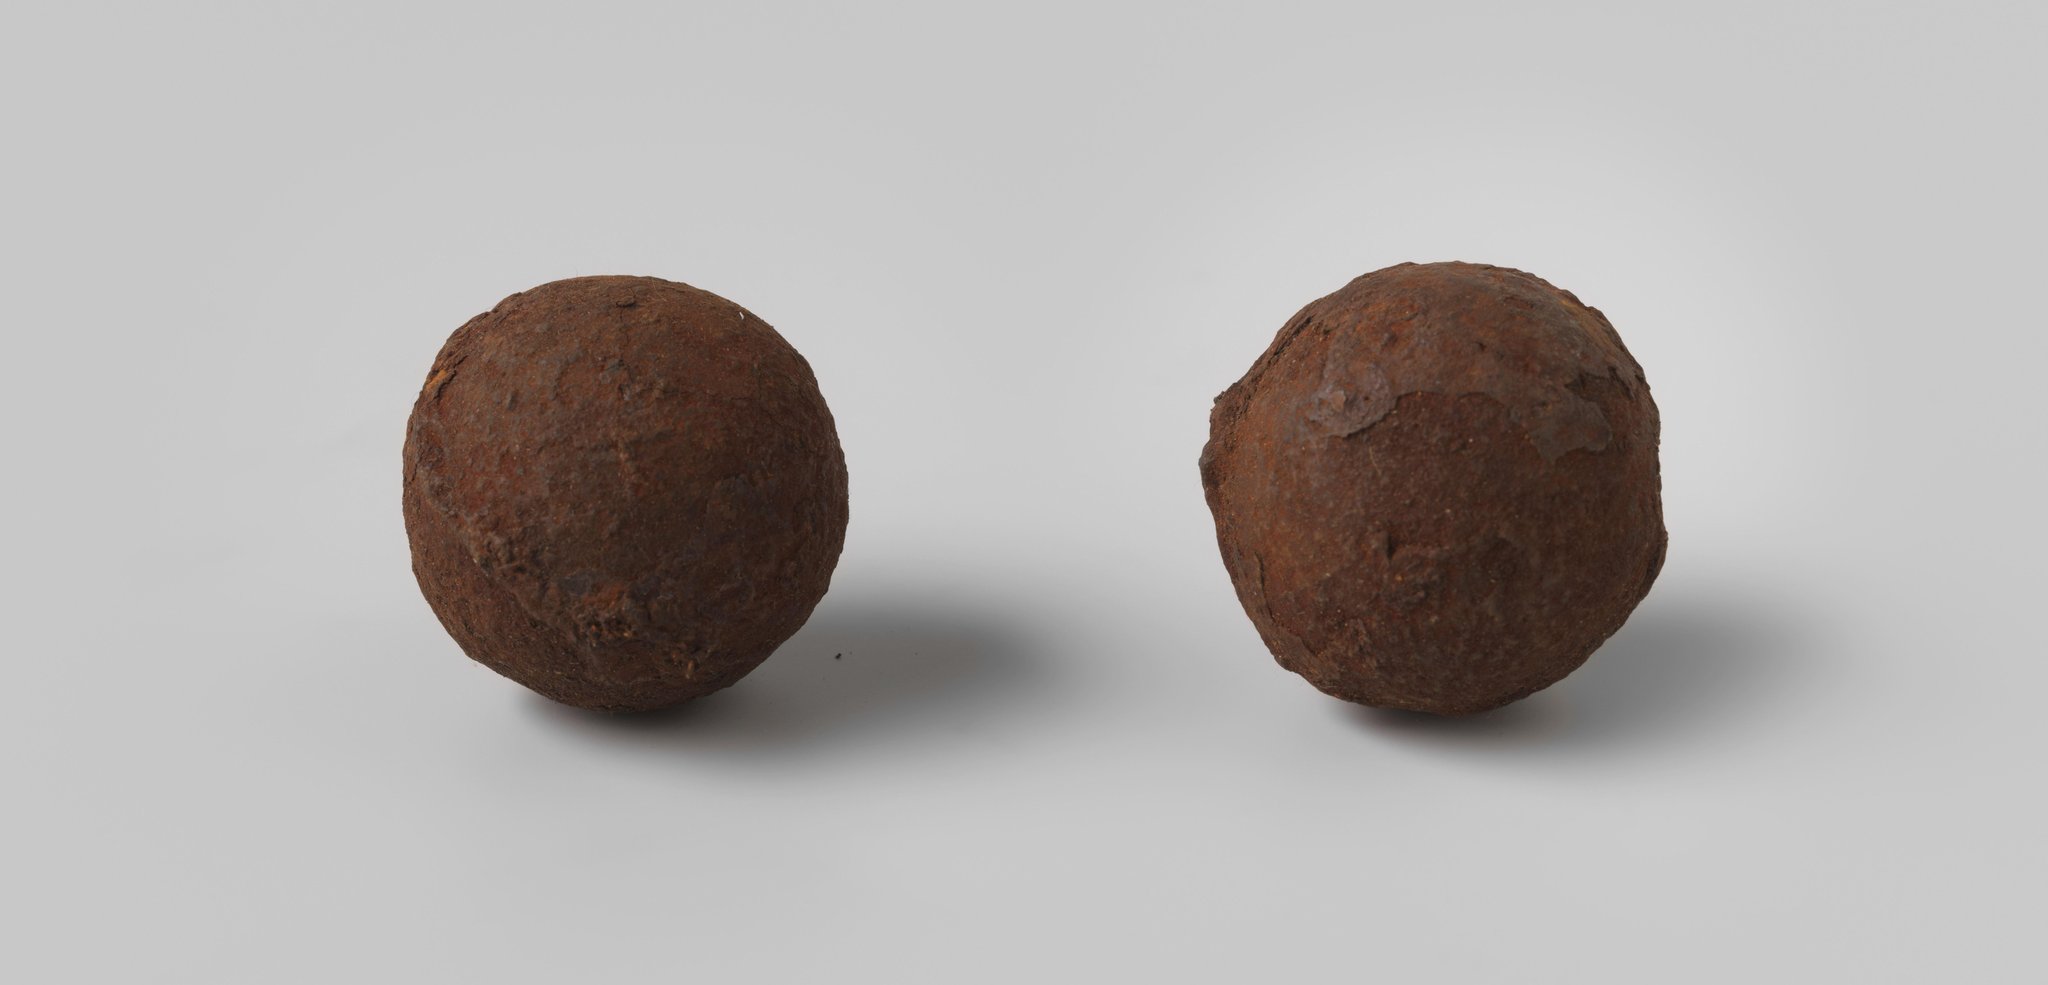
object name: bullet ammunition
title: Kogels uit het wrak van de Oost-Indiëvaarder Hollandia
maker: Anonymous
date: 1700-1743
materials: iron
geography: netherlands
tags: verenigde oostindische compagnie, hollandia (schip), annet